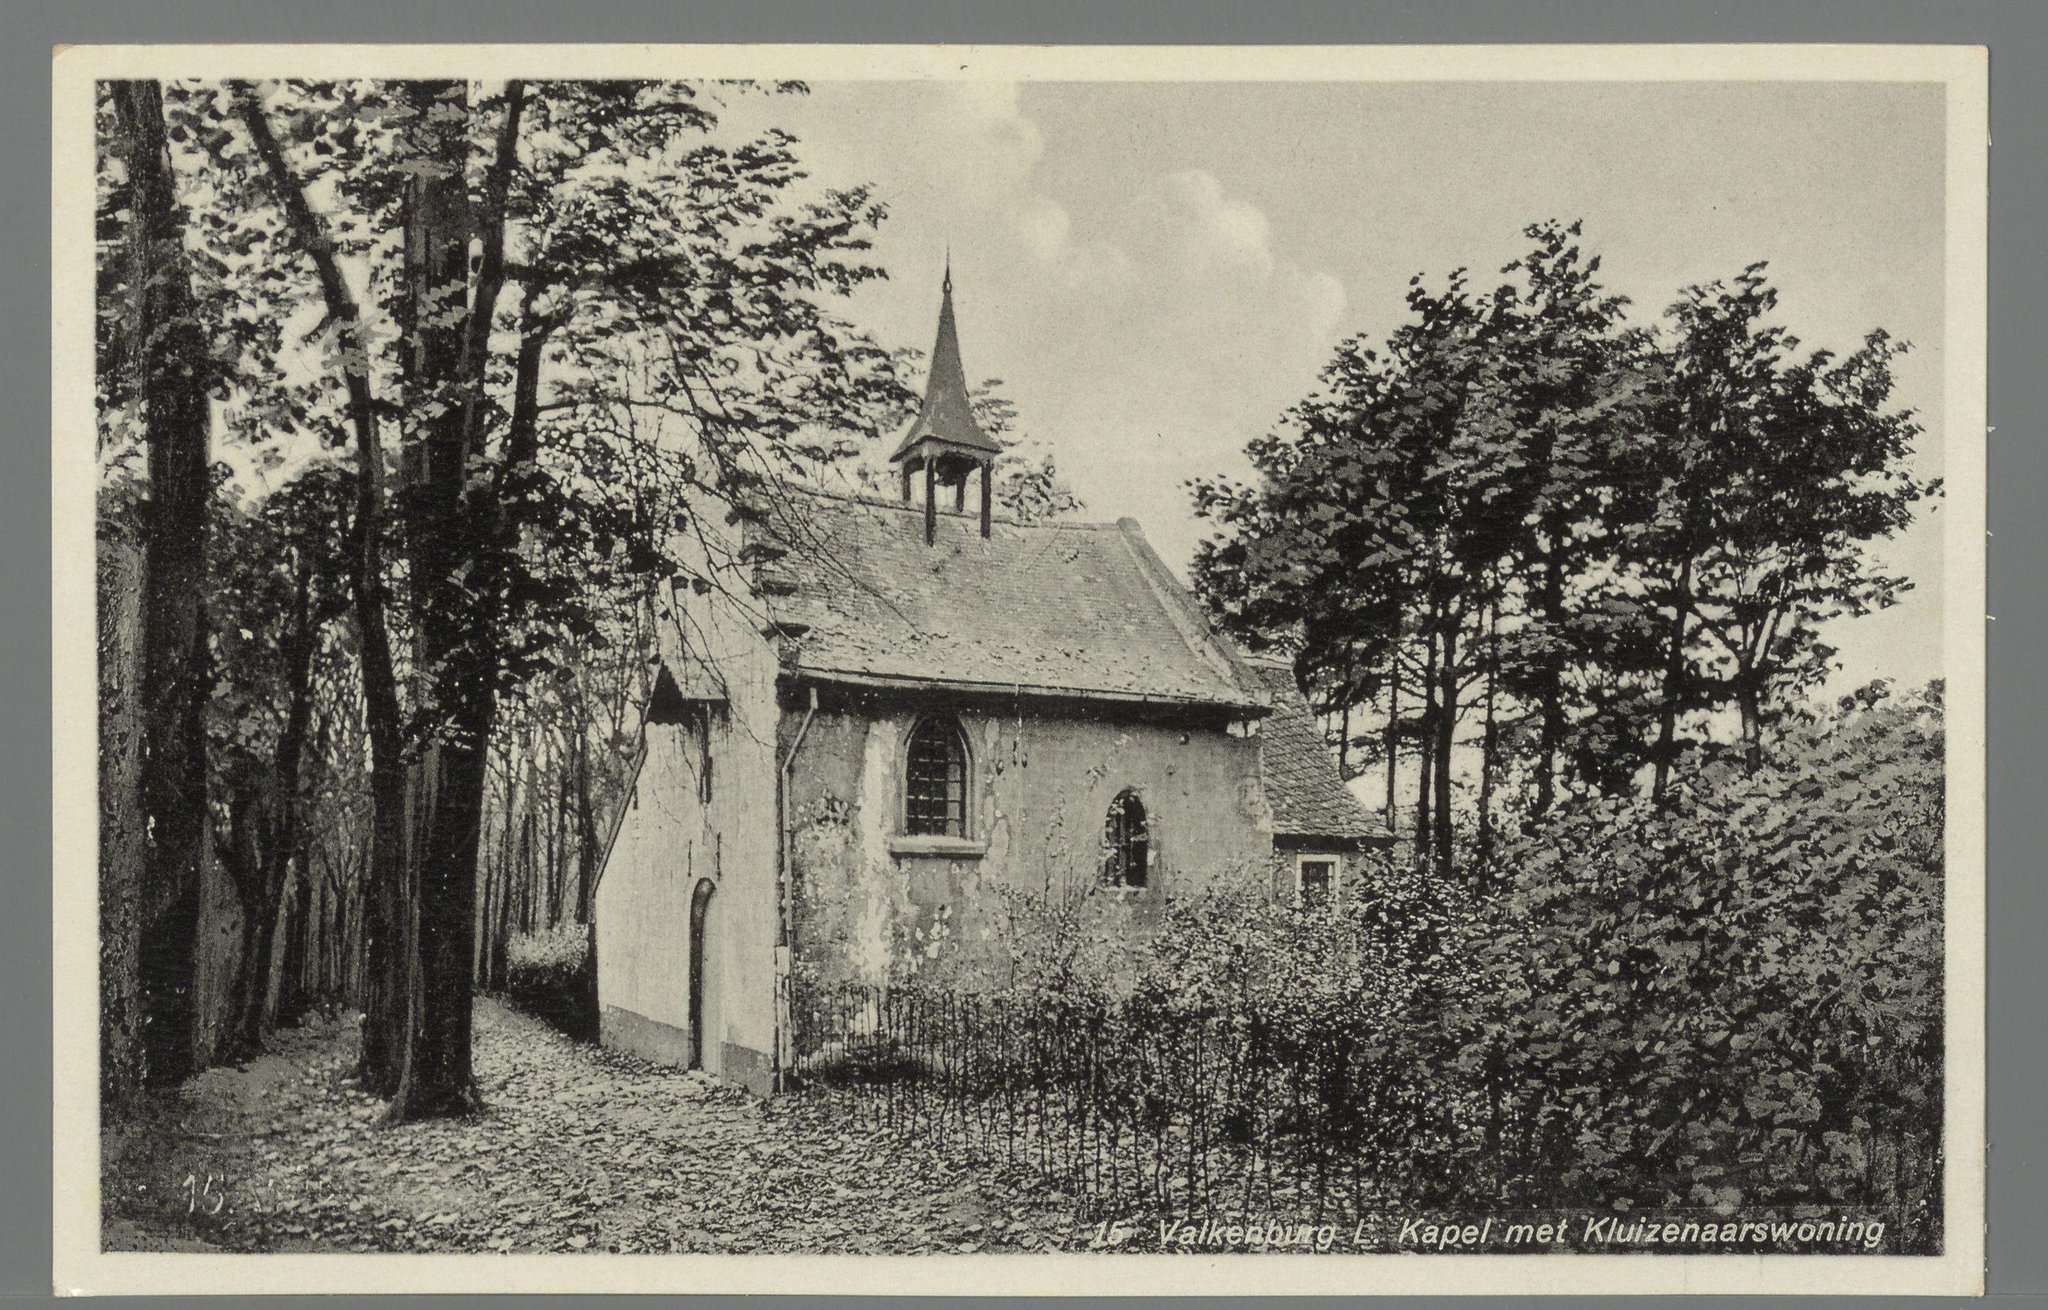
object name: ansichtkaart, prentbriefkaart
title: Valkenburg L. Kapel met kluizenaarswoning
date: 1913-1950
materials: cardboard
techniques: photograph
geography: valkenburg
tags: rural housing, e.g. country-house, villa, cottage, forest, wood